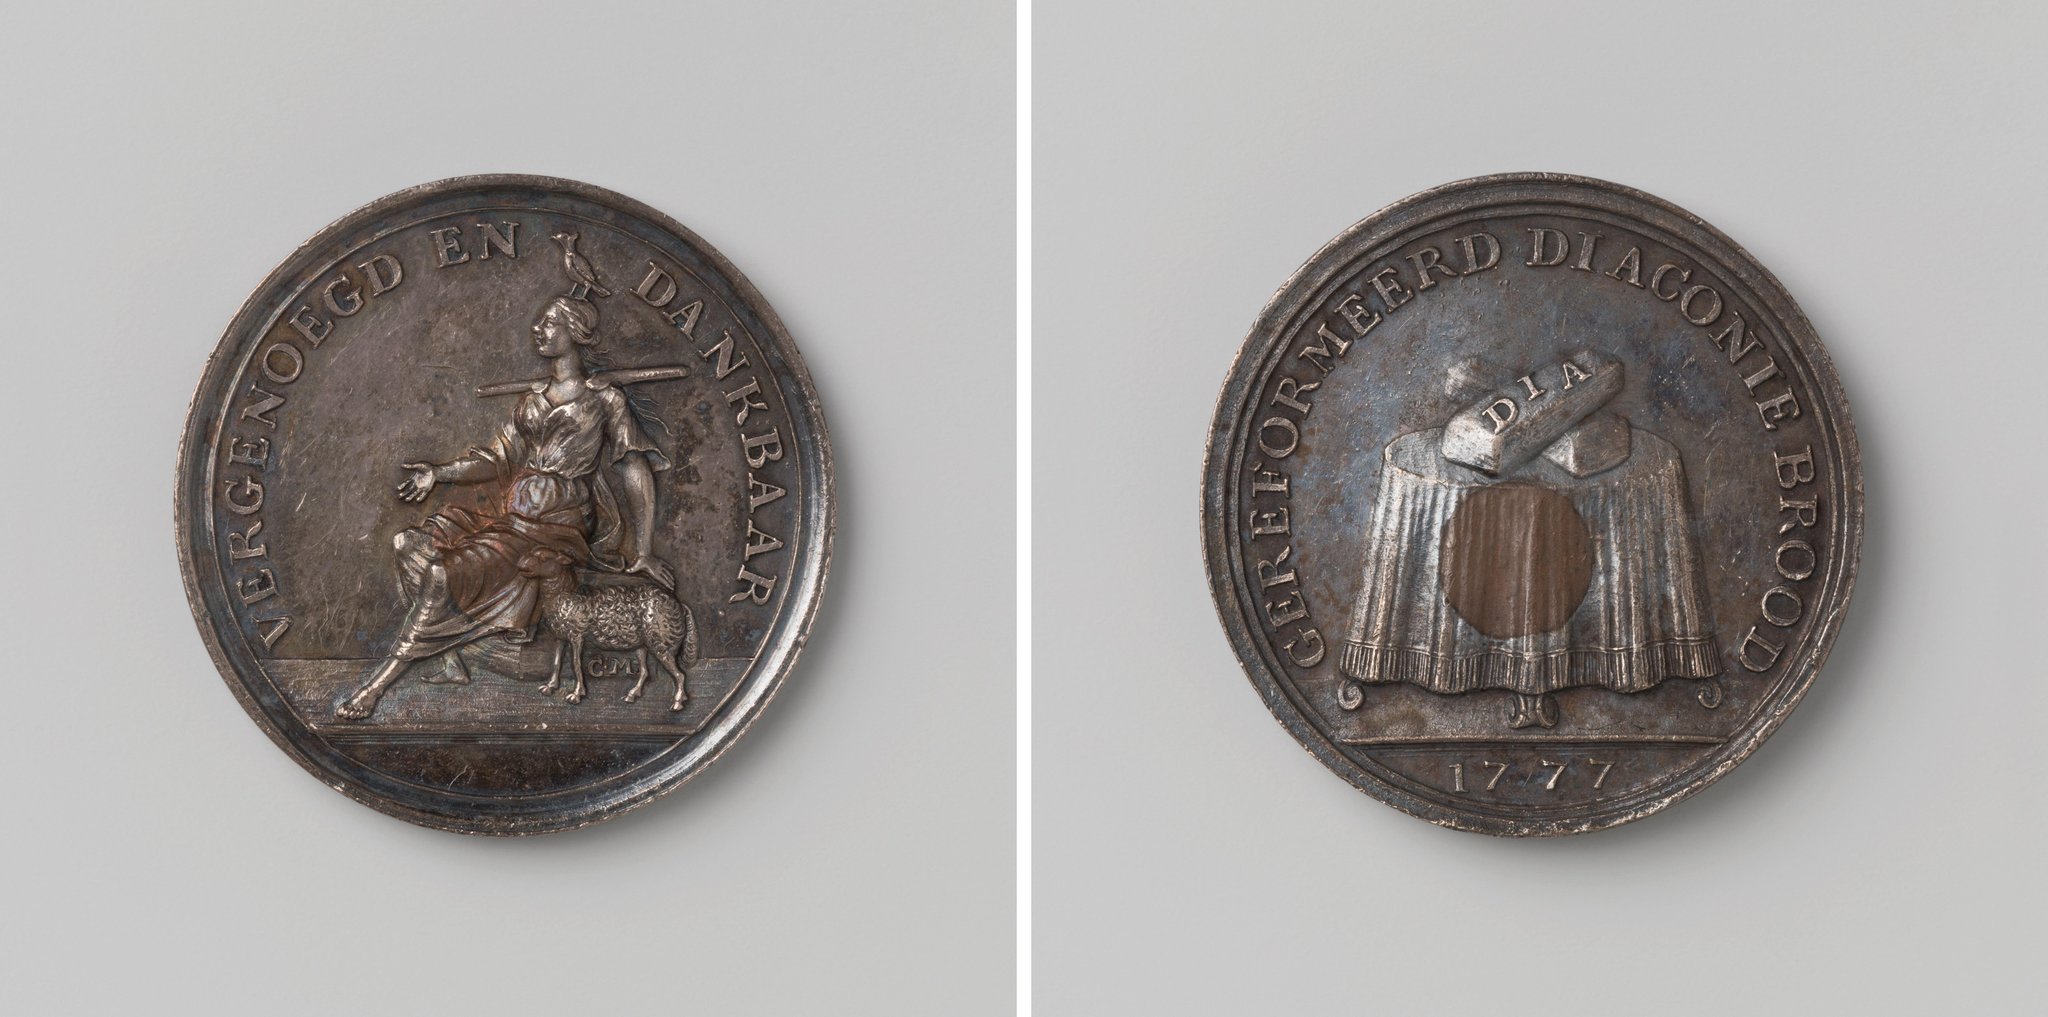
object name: medal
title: Gereformeerde Diakonie te Amsterdam, penning in de vorm van een armenpenning die behoeftige kerklidmaten bij uitdeling recht gaf op brood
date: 1777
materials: copper, silver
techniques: striking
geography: amsterdam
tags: amsterdam